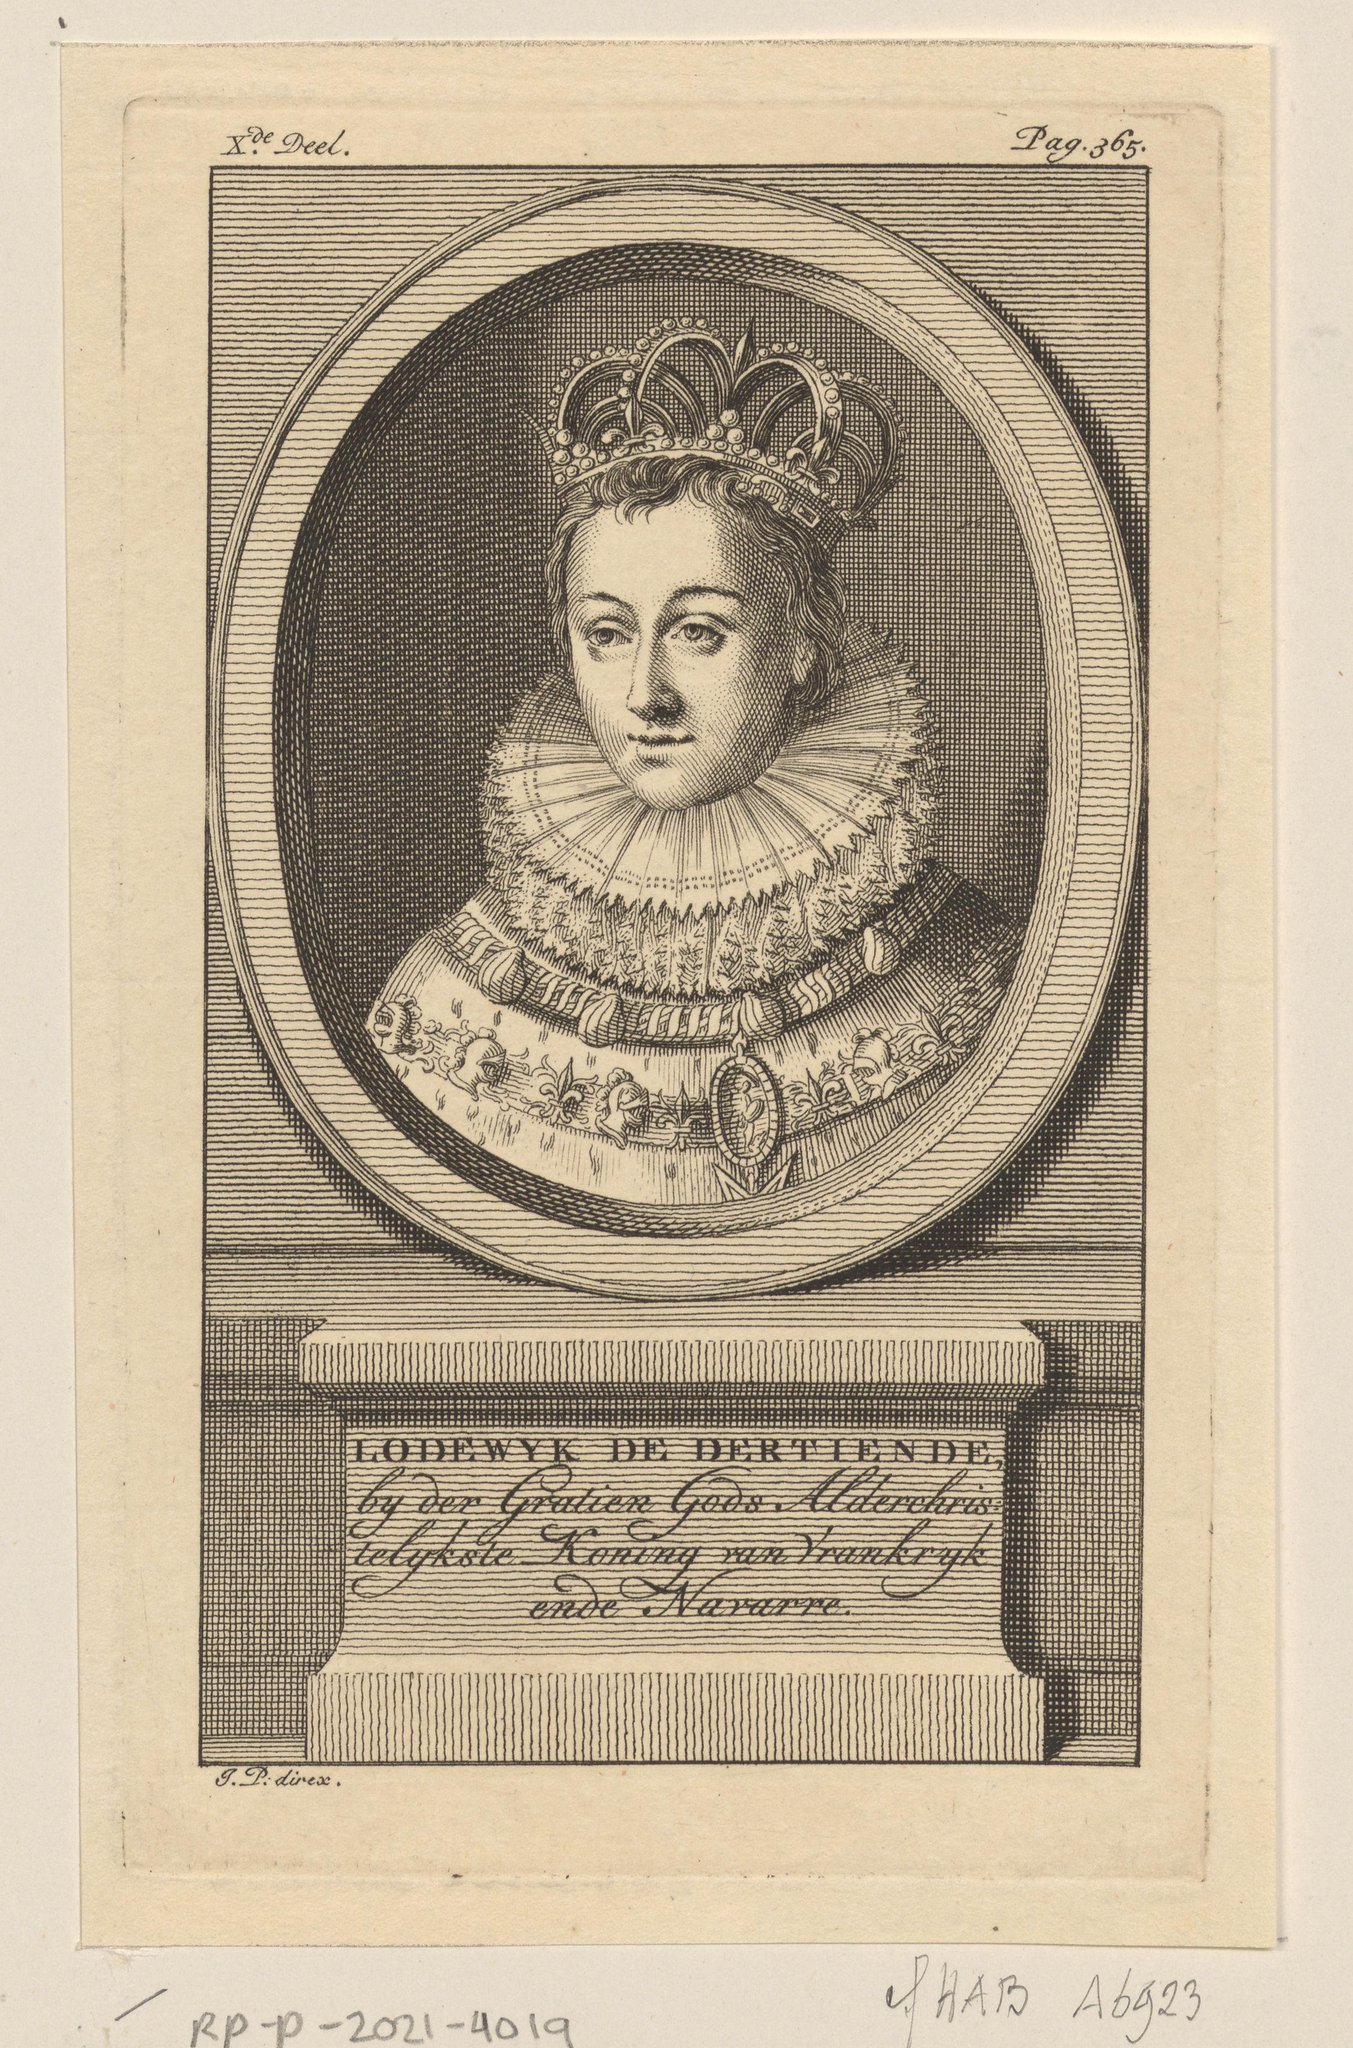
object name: book illustration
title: Portret van Lodewijk XIII van Frankrijk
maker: jan punt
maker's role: draughtsman, print maker, publisher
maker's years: 1711-1779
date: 1763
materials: paper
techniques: etching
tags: lodewijk xiii (koning van frankrijk), crown (symbol of sovereignty), ornament ~ medallion, historical persons, king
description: Prent waarschijnlijk uit: Meteren, Emanuel van. Historie van de oorlogen en geschiedenissen der Nederlanderen, en derzelver Naburen (...). Gorinchem: Nicolaas Goetzee, 1763, dl. 10. Prent is in een latere staat waarschijnlijk gebruikt in de druk uit 1786, zie Van Someren.